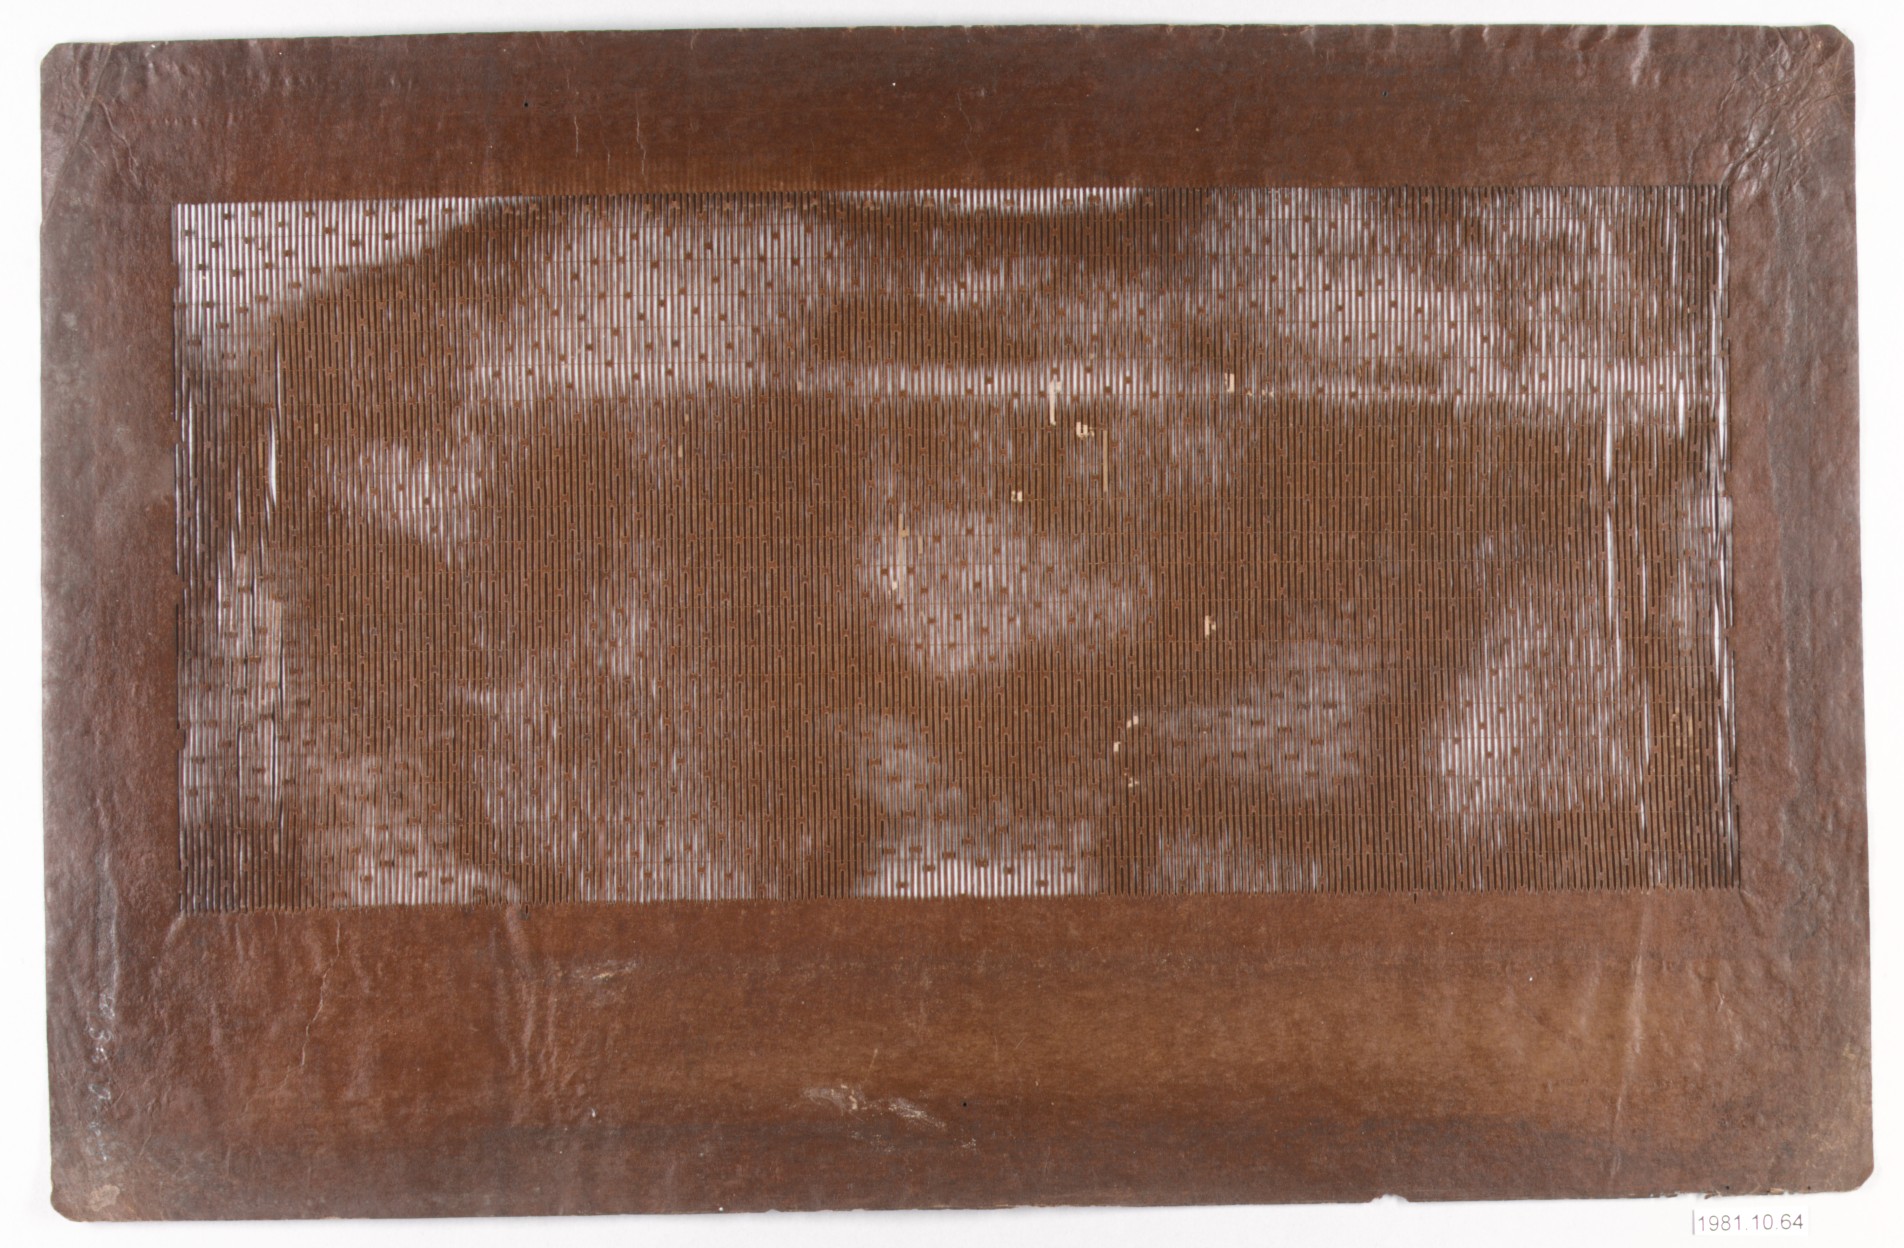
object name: stencil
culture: japanese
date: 1801-1900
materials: paper